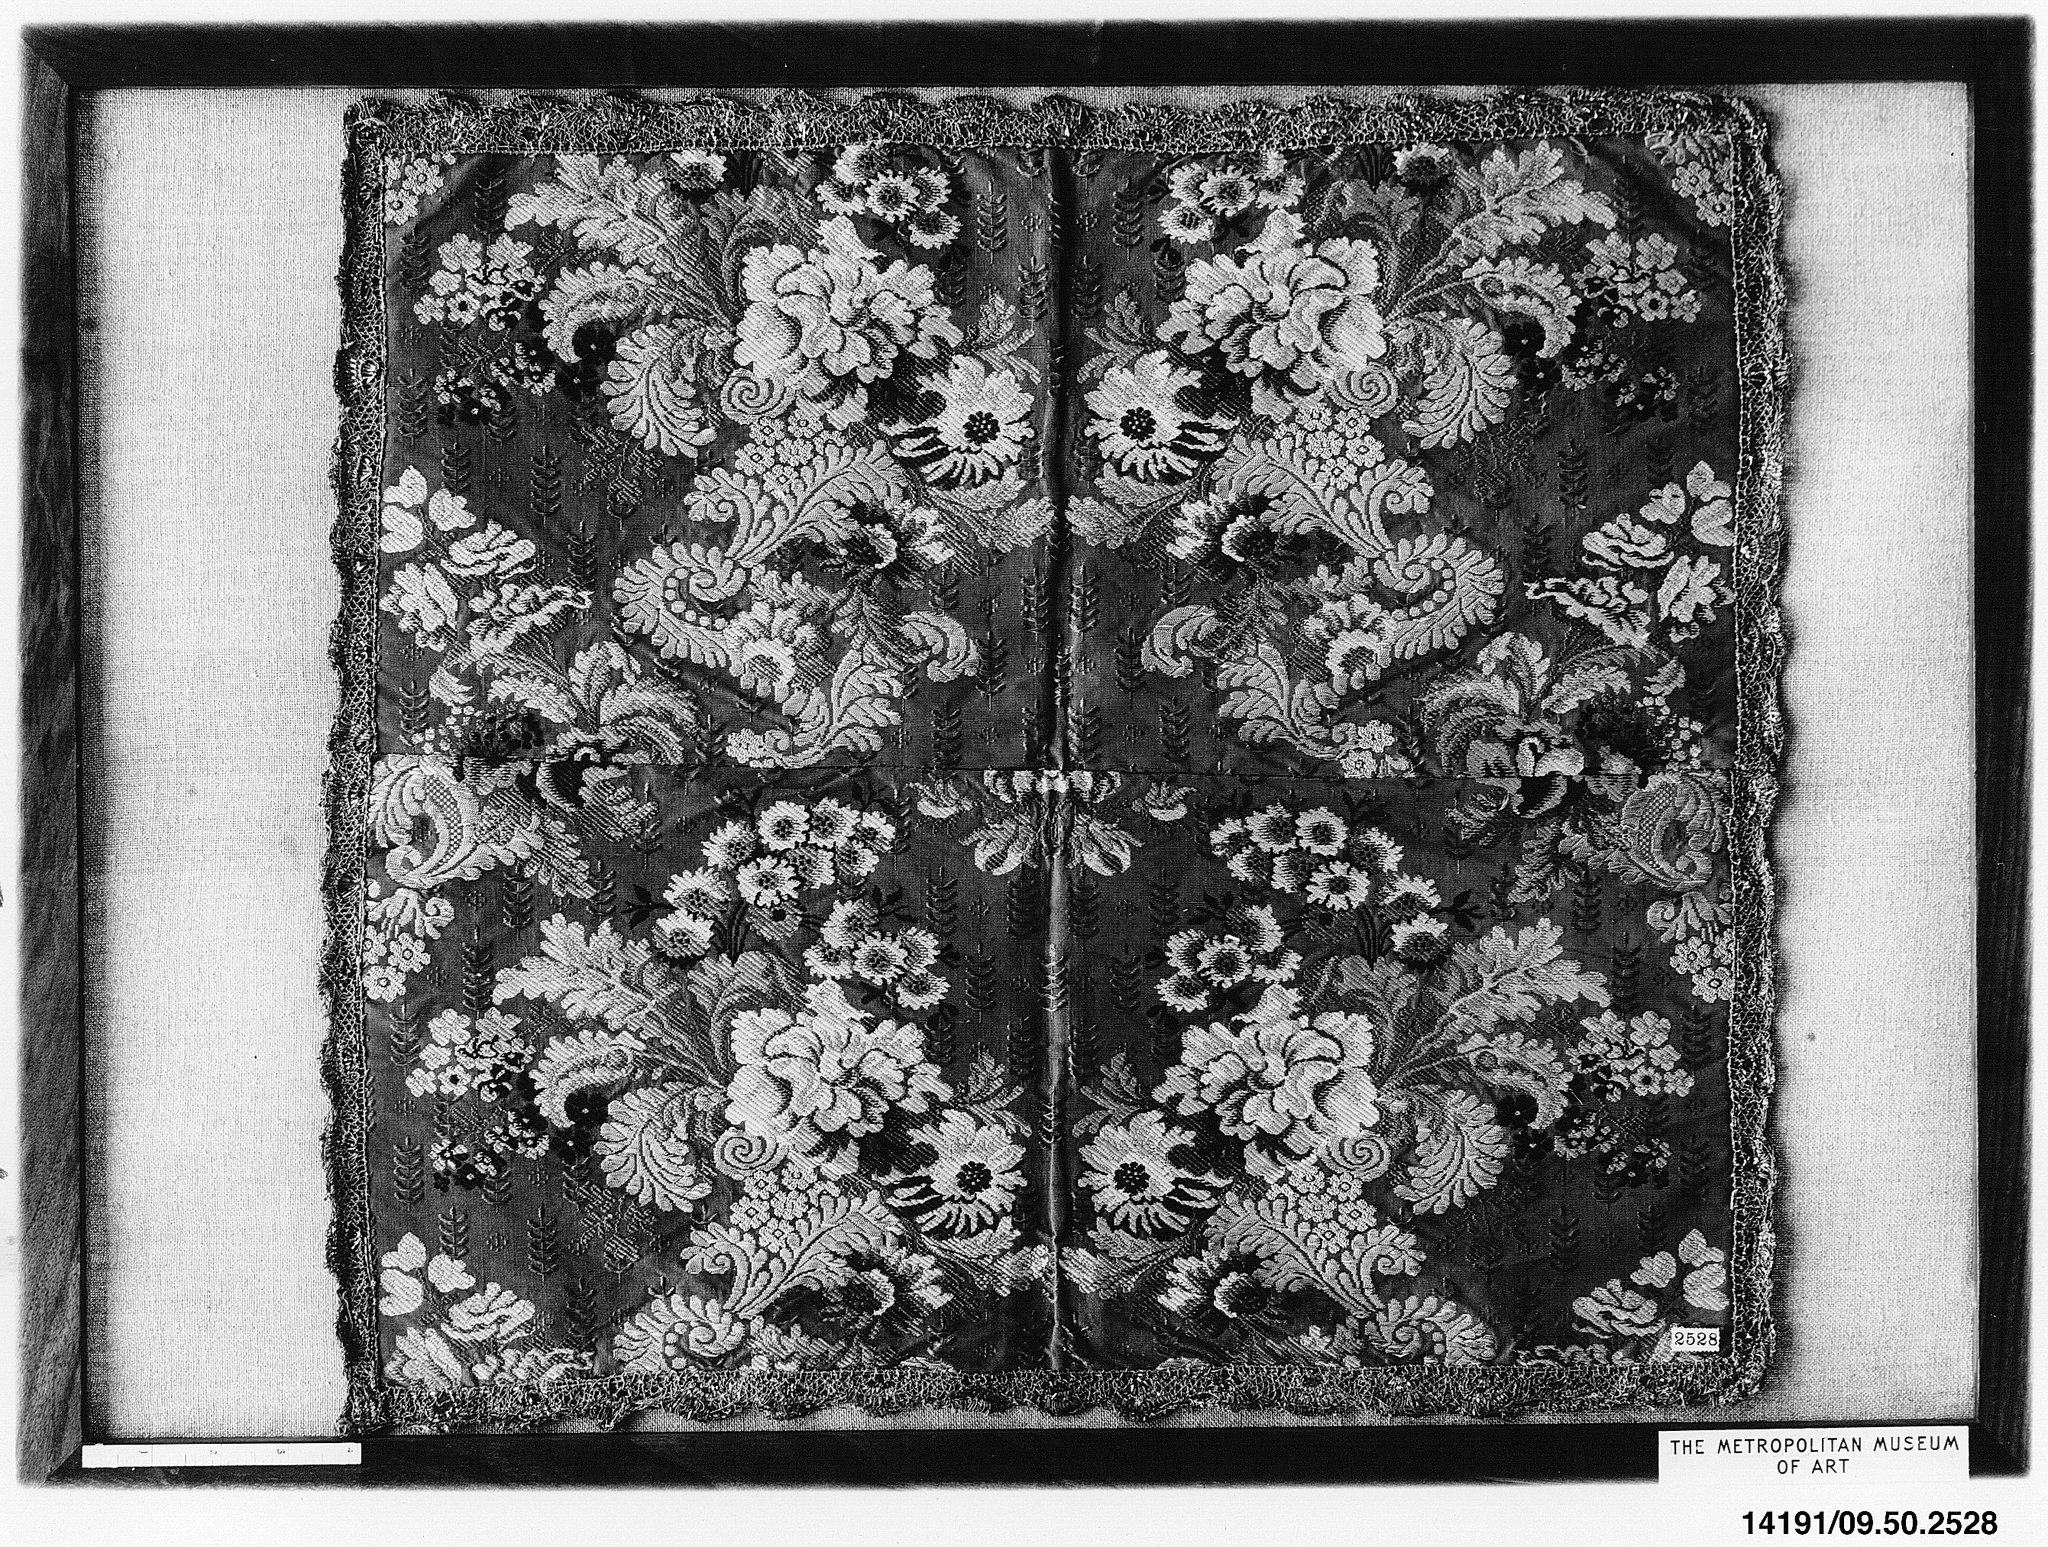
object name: piece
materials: metal thread, silk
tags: flowers,leaves